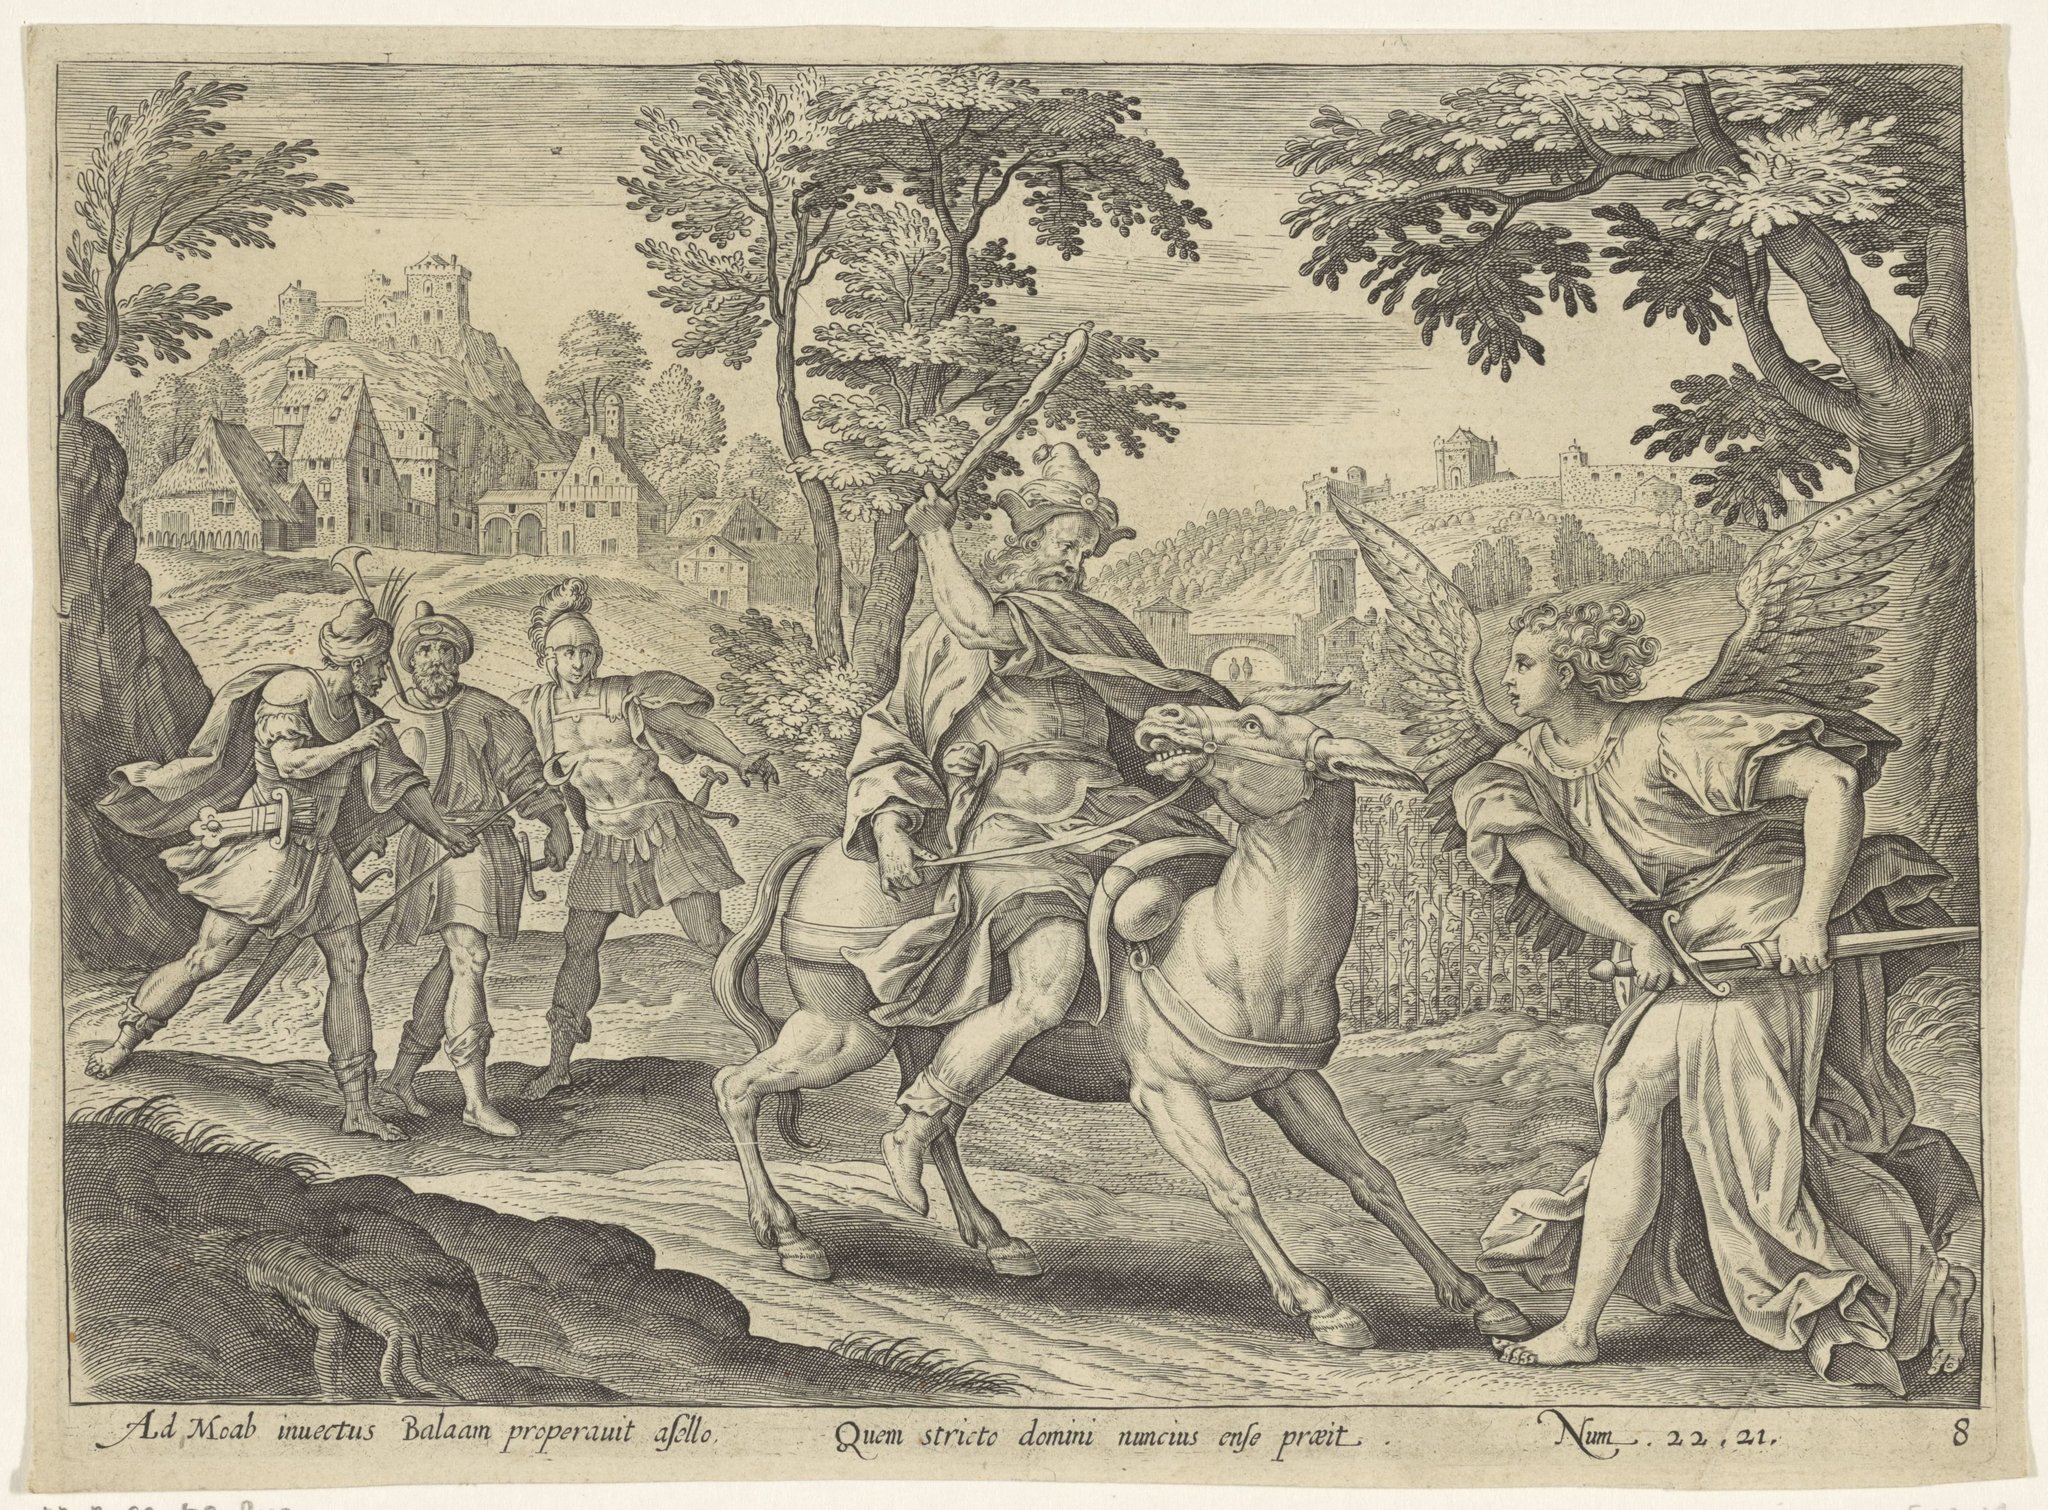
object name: print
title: Geschiedenis van Mozes na de Exodus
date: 1585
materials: paper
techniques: engraving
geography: amsterdam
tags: an angel holding a sword bars the way and causes balaam's ass to turn aside; the angel is invisible to balaam, balaam strikes his ass, whereupon the ass lies down and starts to speak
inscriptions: collector's mark: Lugt 2228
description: Prent oorspronkelijk gebruikt in: Thesaurus sacrarum historiaru[m] veteris (et novi) testame[n]ti, elega[n]tissimis imaginibus expressu[m] excelle[n]tissimoru[m] in hac arte viroru[m] opera : nu[n]c primu[m] in luce[m] editus. Antwerpen: Gerard de Jode, 1585. Deze staat gebruikt in: Theatrum biblicum : hoc est historiae sacrae veteris et novi testamenti tabulis aeneis expressae. Opus praesentatissimorum huius ac superioris seculi pictorum atque sculptorum, summo studio conquisitum et in lucem editum. Amsterdam: Claes Jansz. Visscher, 1643.